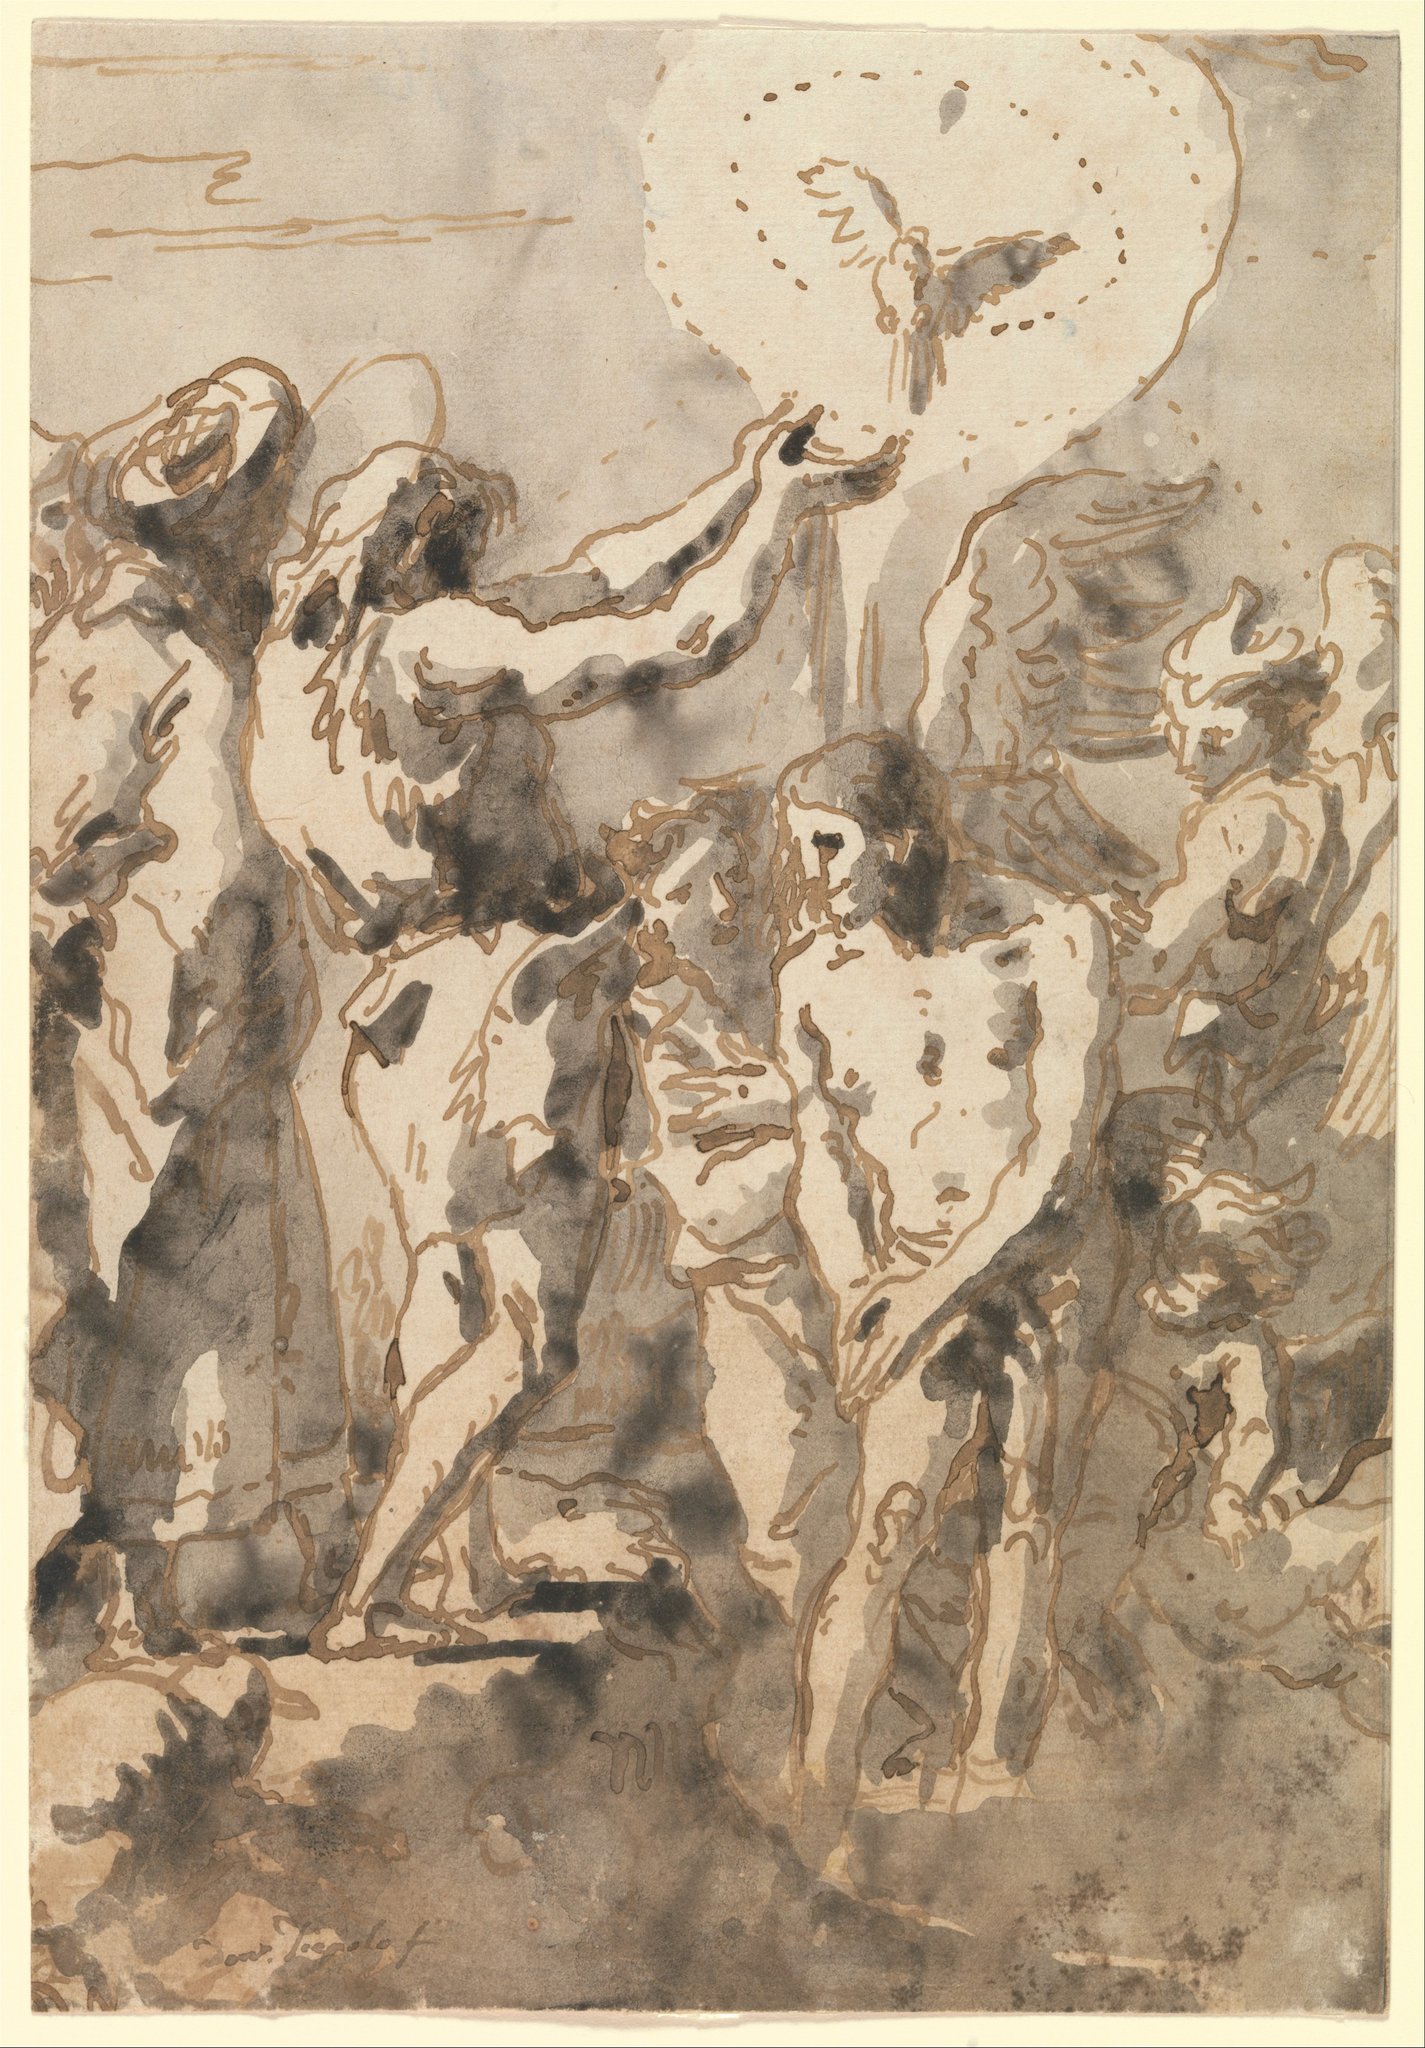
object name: drawing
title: The Baptism of Christ (with Saint John, Without his Cross, in Profile to the Right)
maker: giovanni domenico tiepolo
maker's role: artist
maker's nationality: italian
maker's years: 1727-1804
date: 1770-1790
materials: ink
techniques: pen, wash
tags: saint john the baptist,baptism of christ